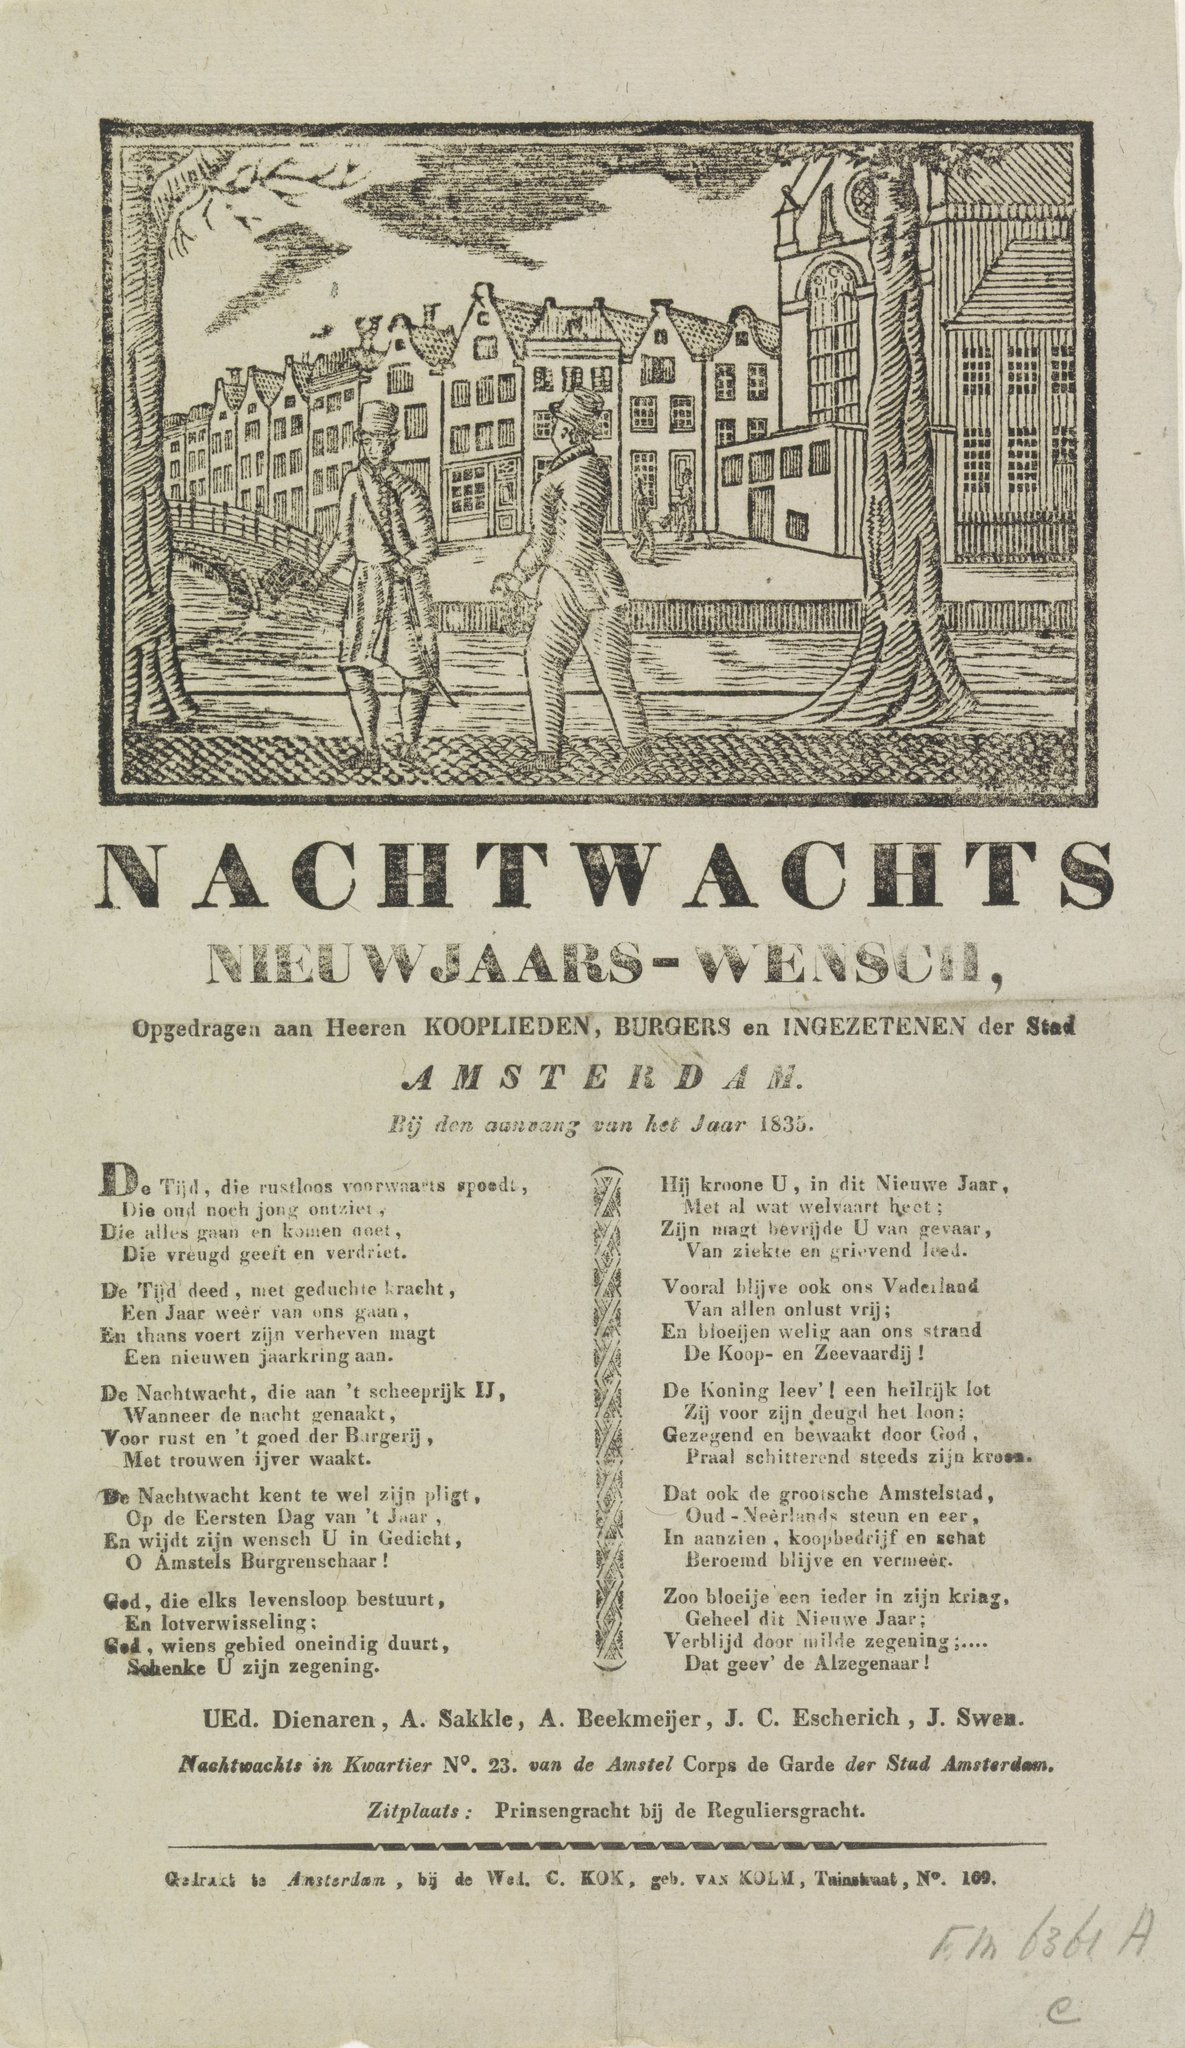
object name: new year card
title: Nachtwachts Nieuwjaars-wensch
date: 1834-1835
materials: paper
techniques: letterpress printing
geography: amsterdam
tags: night patrol, street, amsterdam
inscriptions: collector's mark: Lugt 2228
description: Nieuwjaarswens van de Amsterdamse nachtwacht (ratelwacht) voor het jaar 1835. Twee leden van de nachtwacht lopend met een ratel bij het Amstelveld in Amsterdam. Met een vers in twee kolommen. Namens de nachtwacht in kwartier No. 23 van de Amstel Corps de Garde der stad Amsterdam: J. Sakkle, A. Beekmeijer, J.C. Escherich en J. Swen.